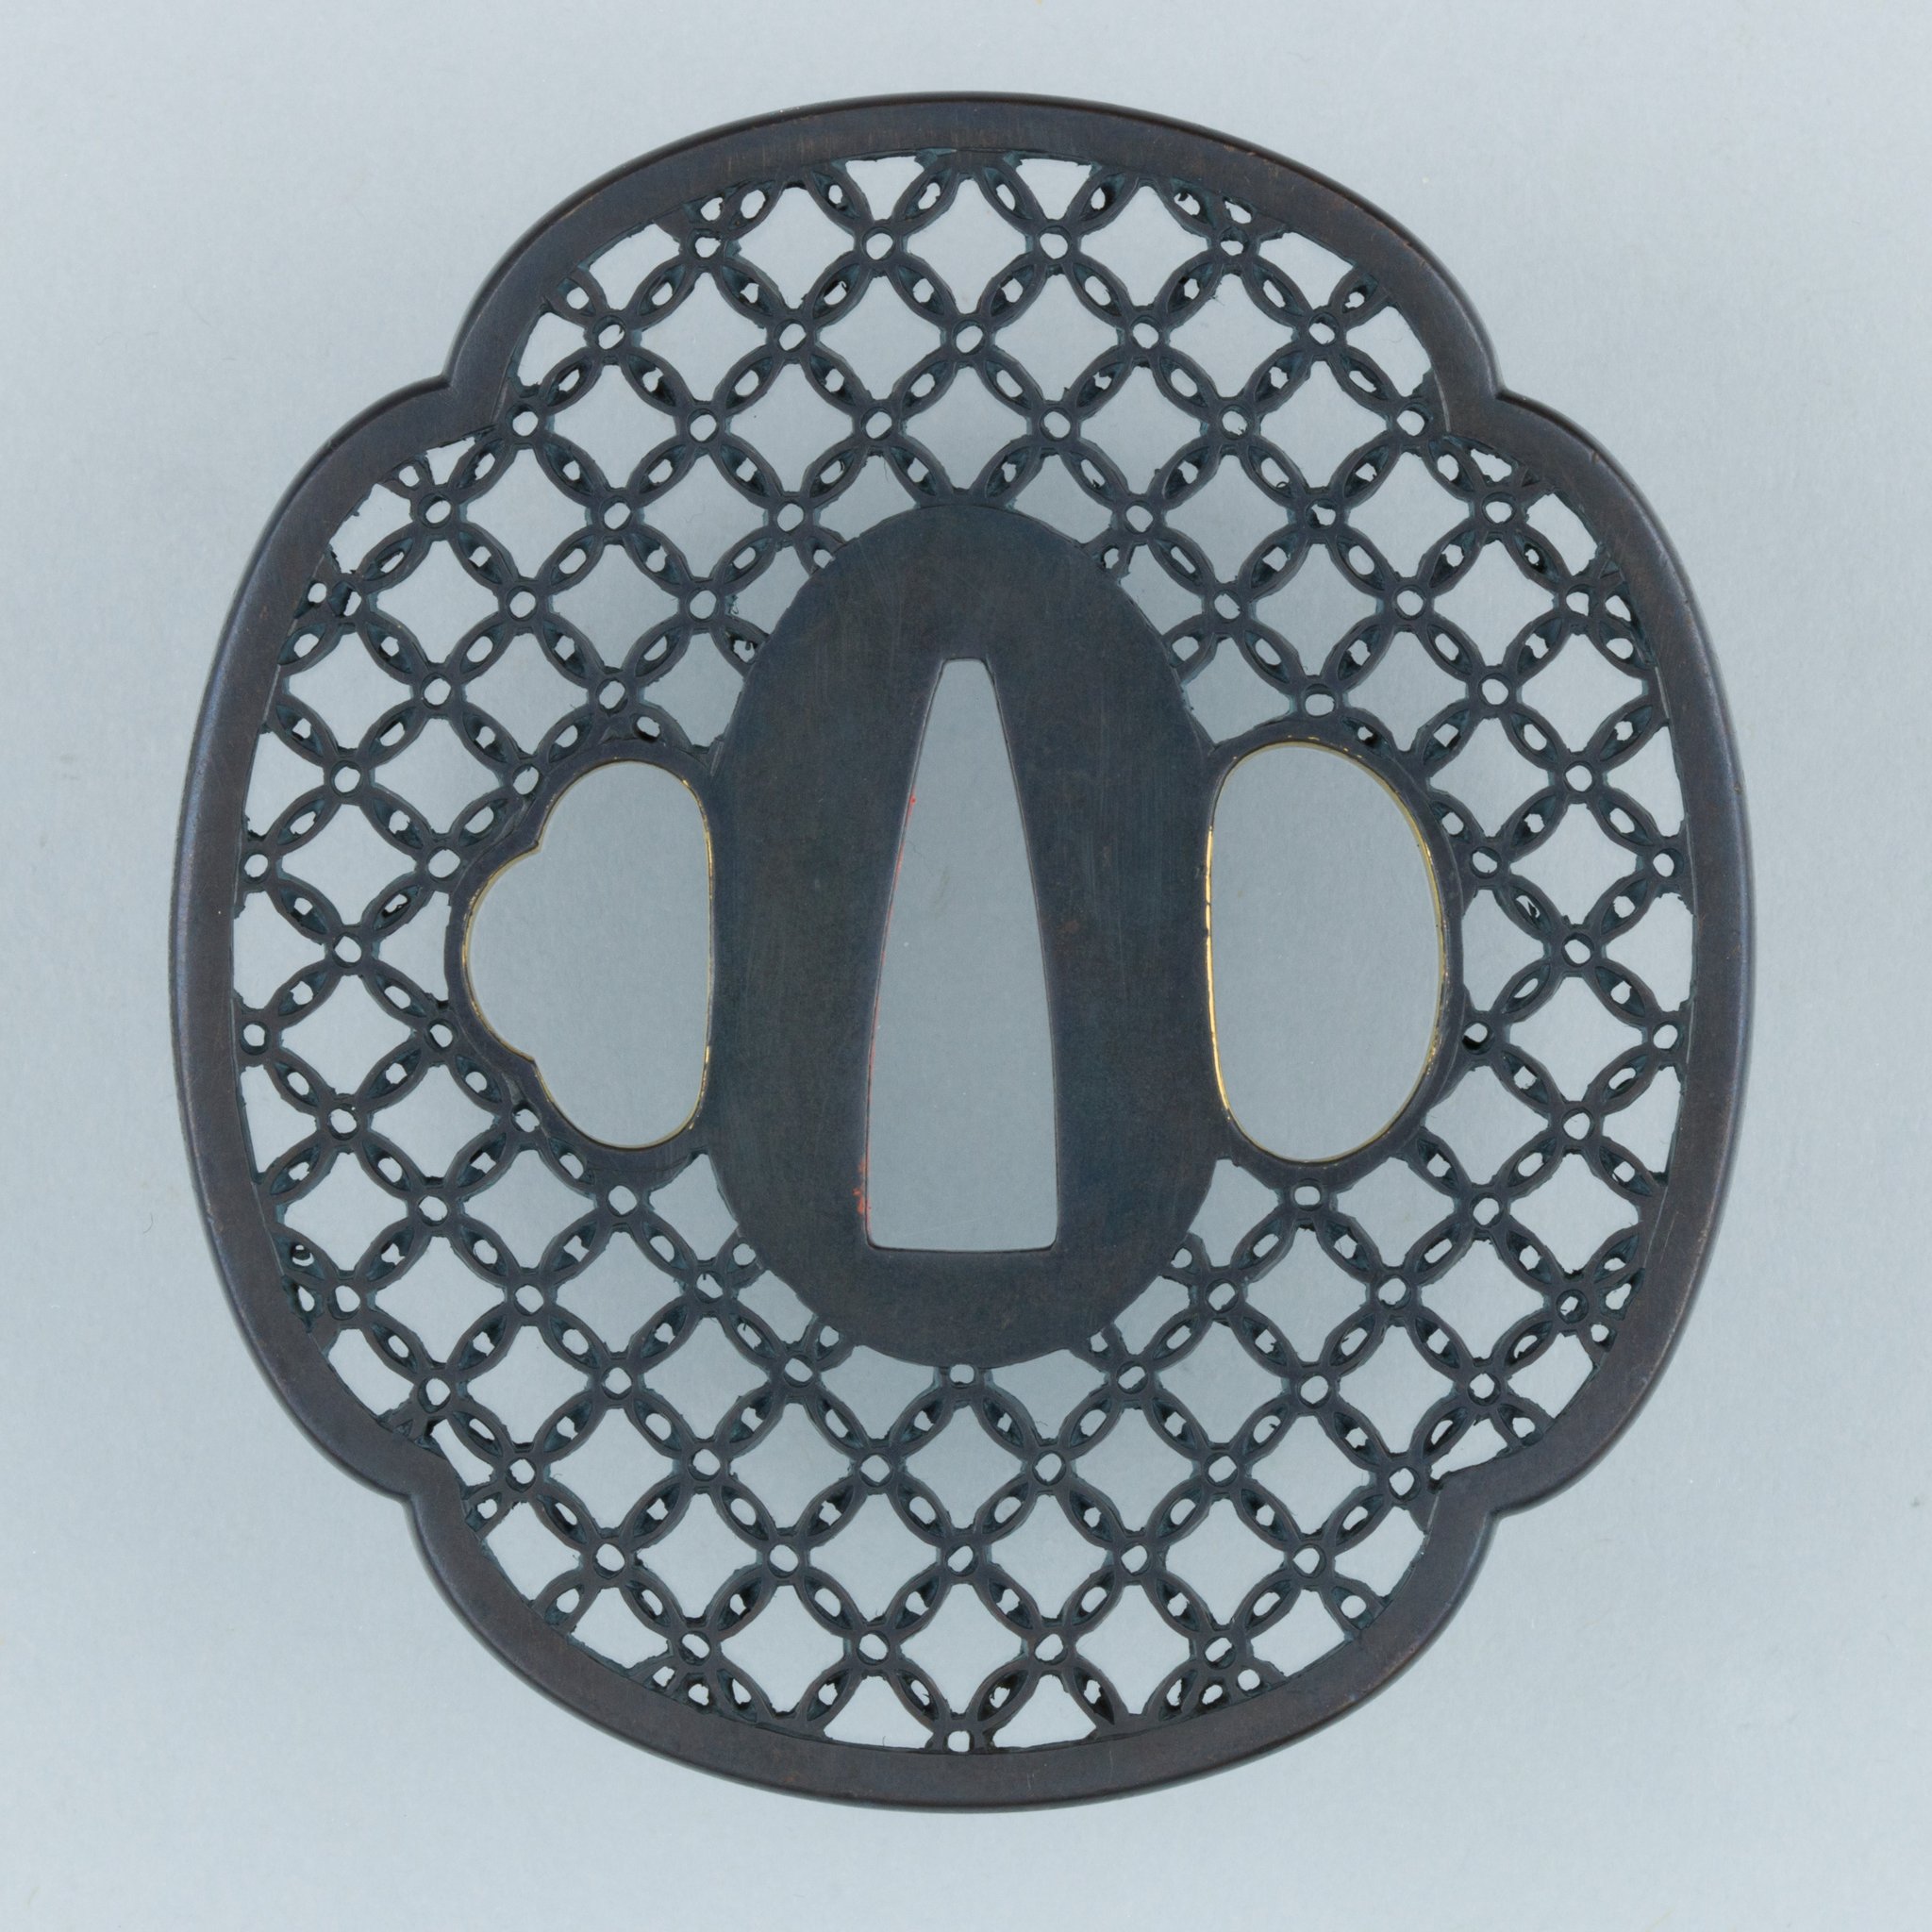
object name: sword guard tsuba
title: Sword Guard (Tsuba)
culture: japanese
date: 1615-1868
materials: copper, gold alloy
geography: japan